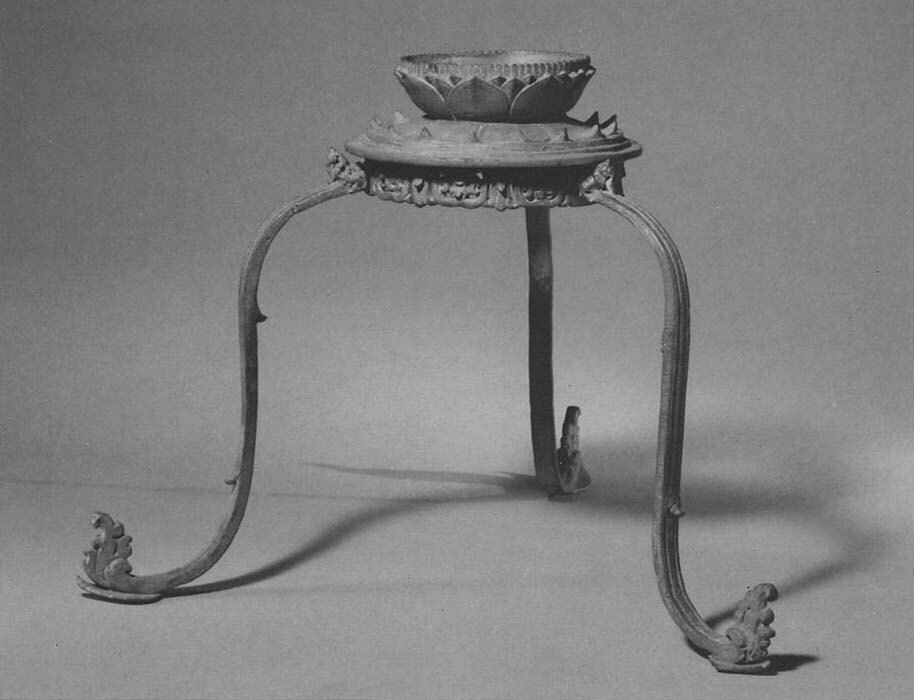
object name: tripod support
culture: indonesian, javanese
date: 901-1033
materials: bronze